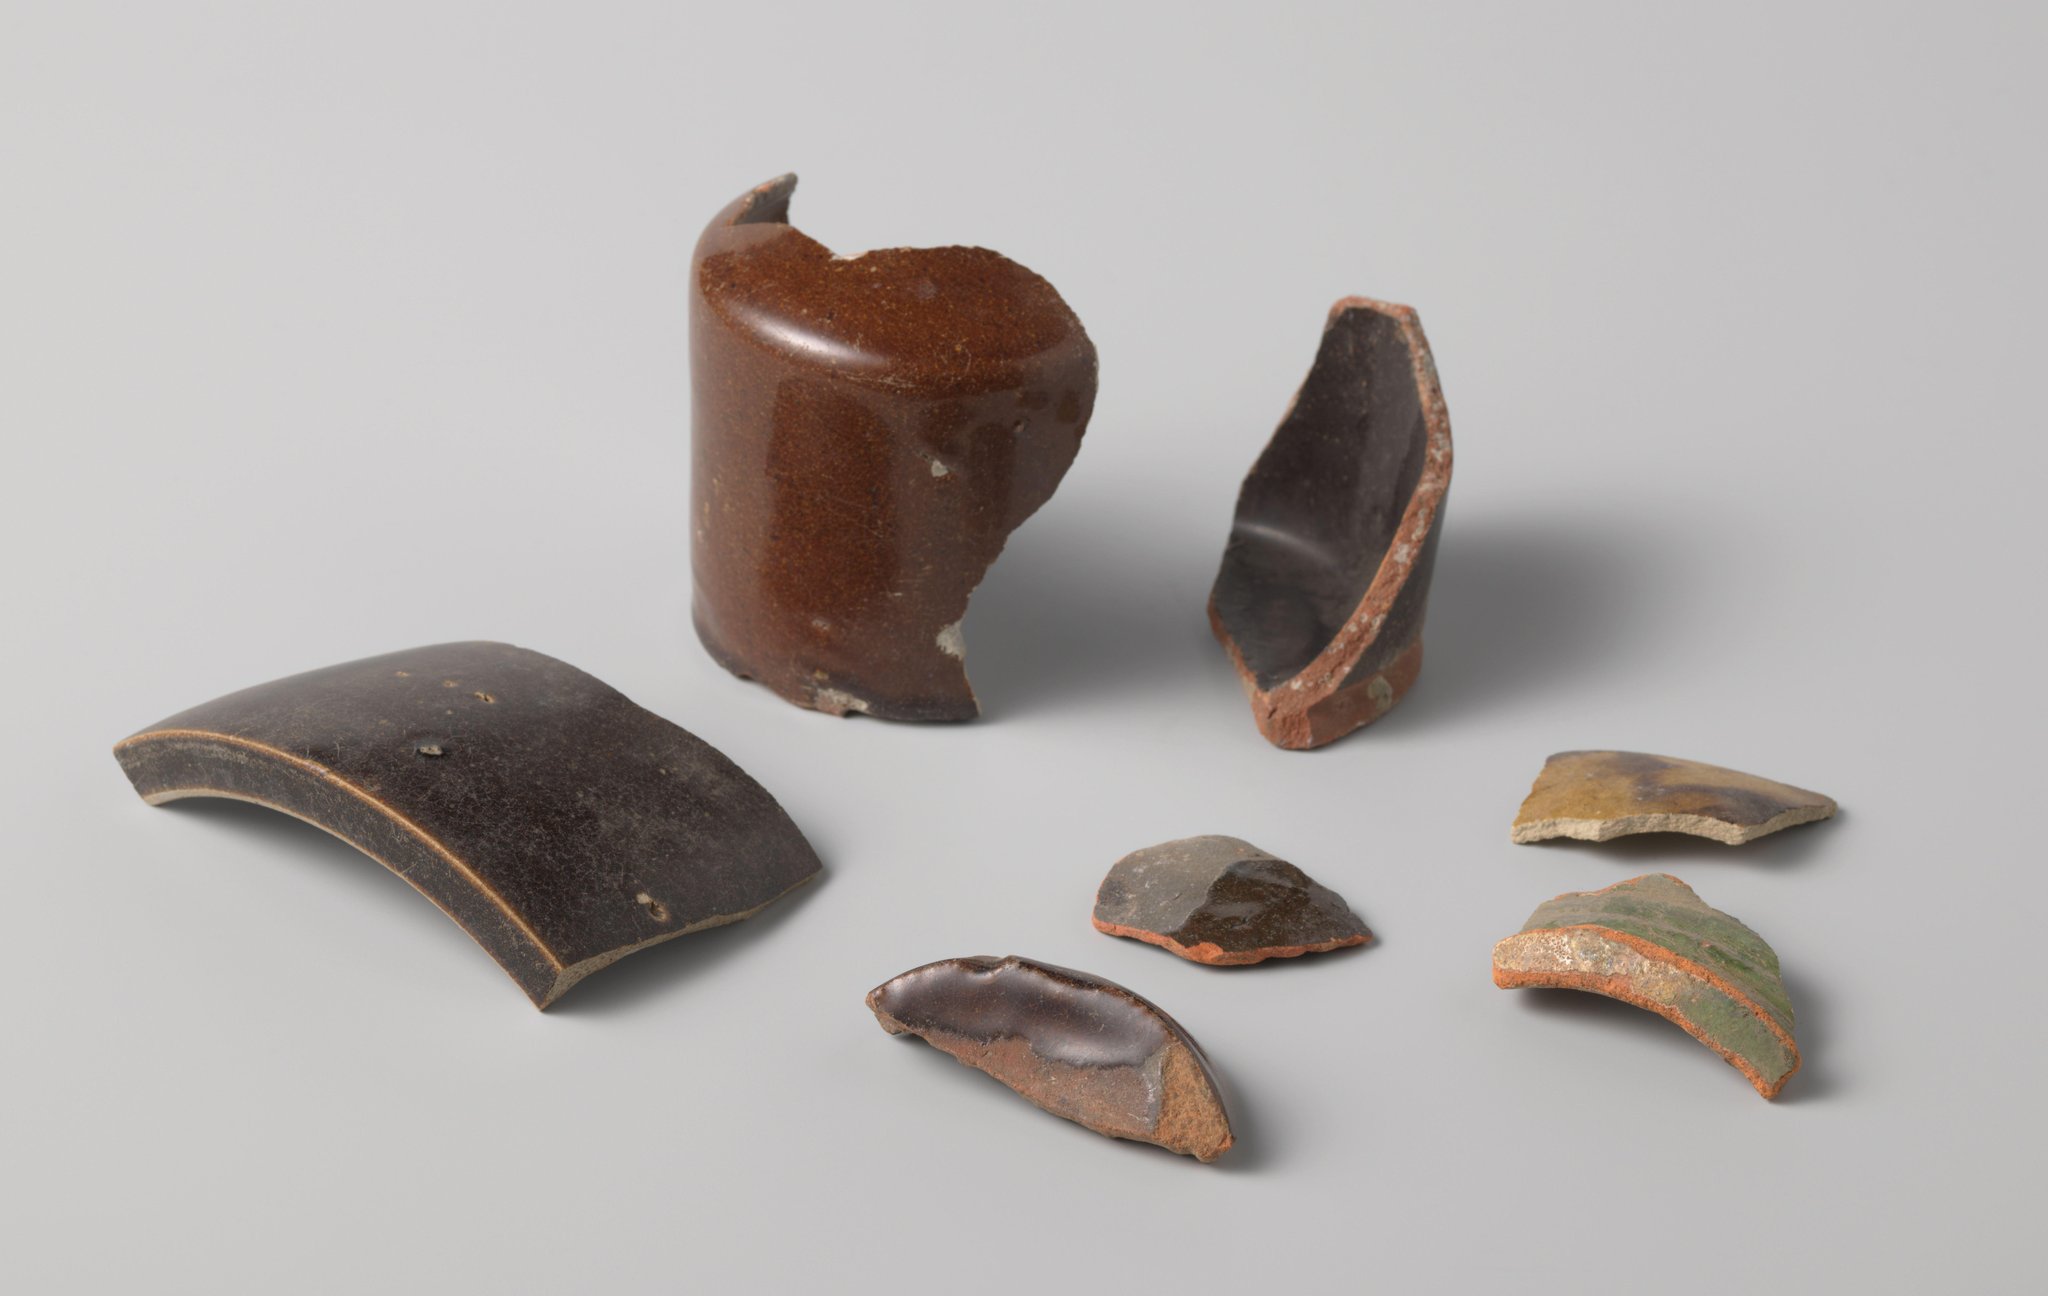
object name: sherd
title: Zeven scherven aardewerk, gevonden bij V.O.C.-schip Witte Leeuw, mogelijk afkomstig van Zeelelie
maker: Anonymous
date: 1750-1799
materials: earthenware, glaze, stoneware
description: Zeven scherven aardewerk met glazuur, één steengoed, één witbakkend en vijf roodbakkend, gevonden bij V.O.C.-schip de 'Witte Leeuw'. Dit object is 18e-eeuws en kan dus niet van de vracht van de Witte Leeuw zijn. Onduidelijk is of het object van de site komt of dat het later is vermengd, mogelijk met materiaal van de Zeelelie.